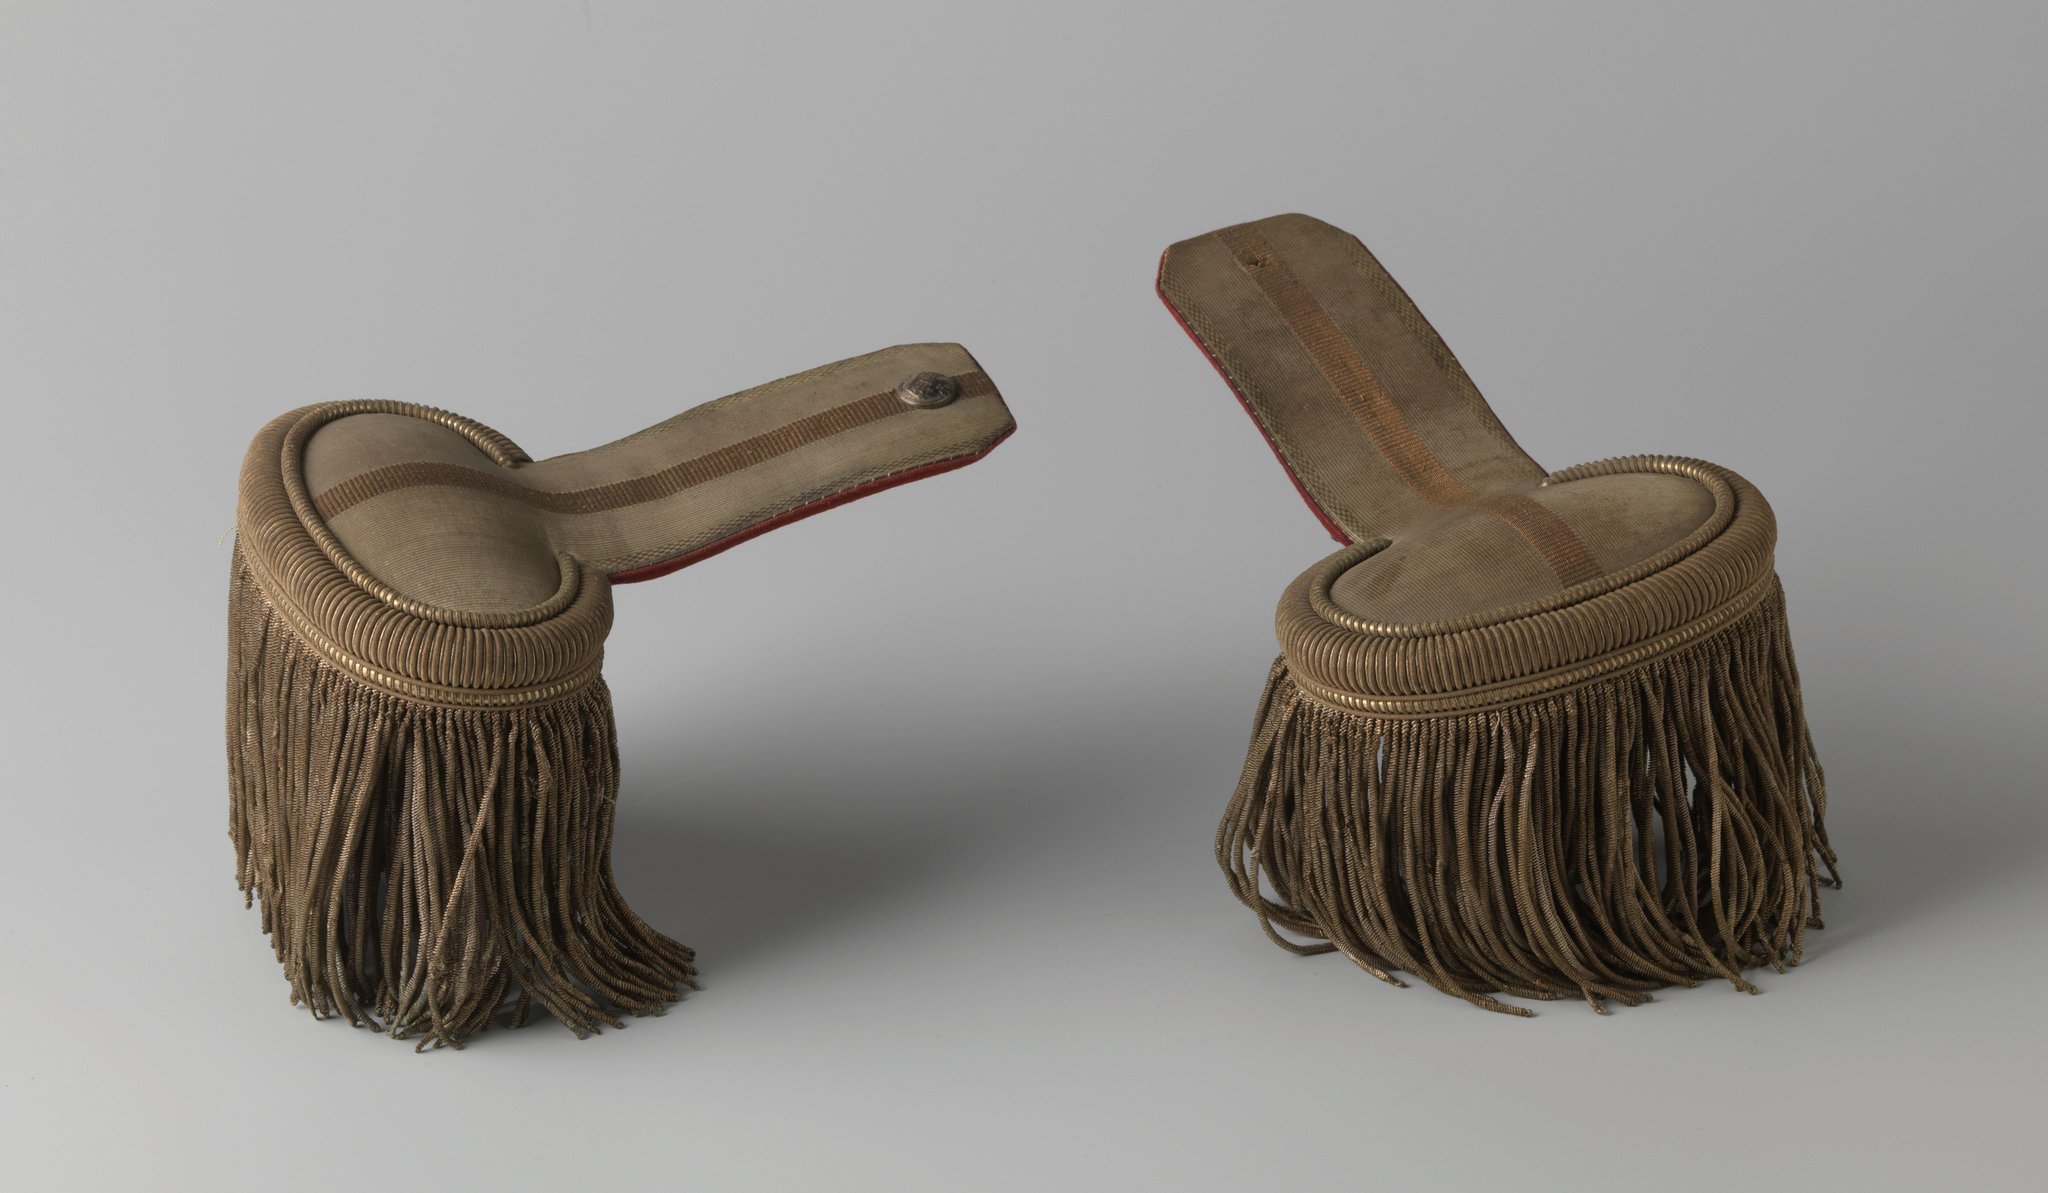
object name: epaulet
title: Paar epauletten gedragen door H.C. Broos in 1830/32 2e luitenant, 1e bat., 2e Afd. N.H. Schutterij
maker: Anonymous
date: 1830-1840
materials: textile, metal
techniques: stitching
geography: north holland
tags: netherlands, belgium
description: Een paar epauletten, elk epaulet van zilvergalon, met een ingeweven baan van zilvergalon op de tong. Het ovale blad is deels omgeven met galon van zilverkoord. Op een tong een wit metalen knoop waarop, in een gestileerde krans een kroon in de vorm van een ommuurde stad: drie poorten en twee muren. Aan het ovale blad afhangende zilveren franje. Onderzijde epaulet gevoerd met rood laken, onder het knoopsgat een geel metalen haak. Onder een der tongen een vierkant papier met het nummer 56. Onder de beide bladen elk een halvemaanvormig wit lakense kussen.